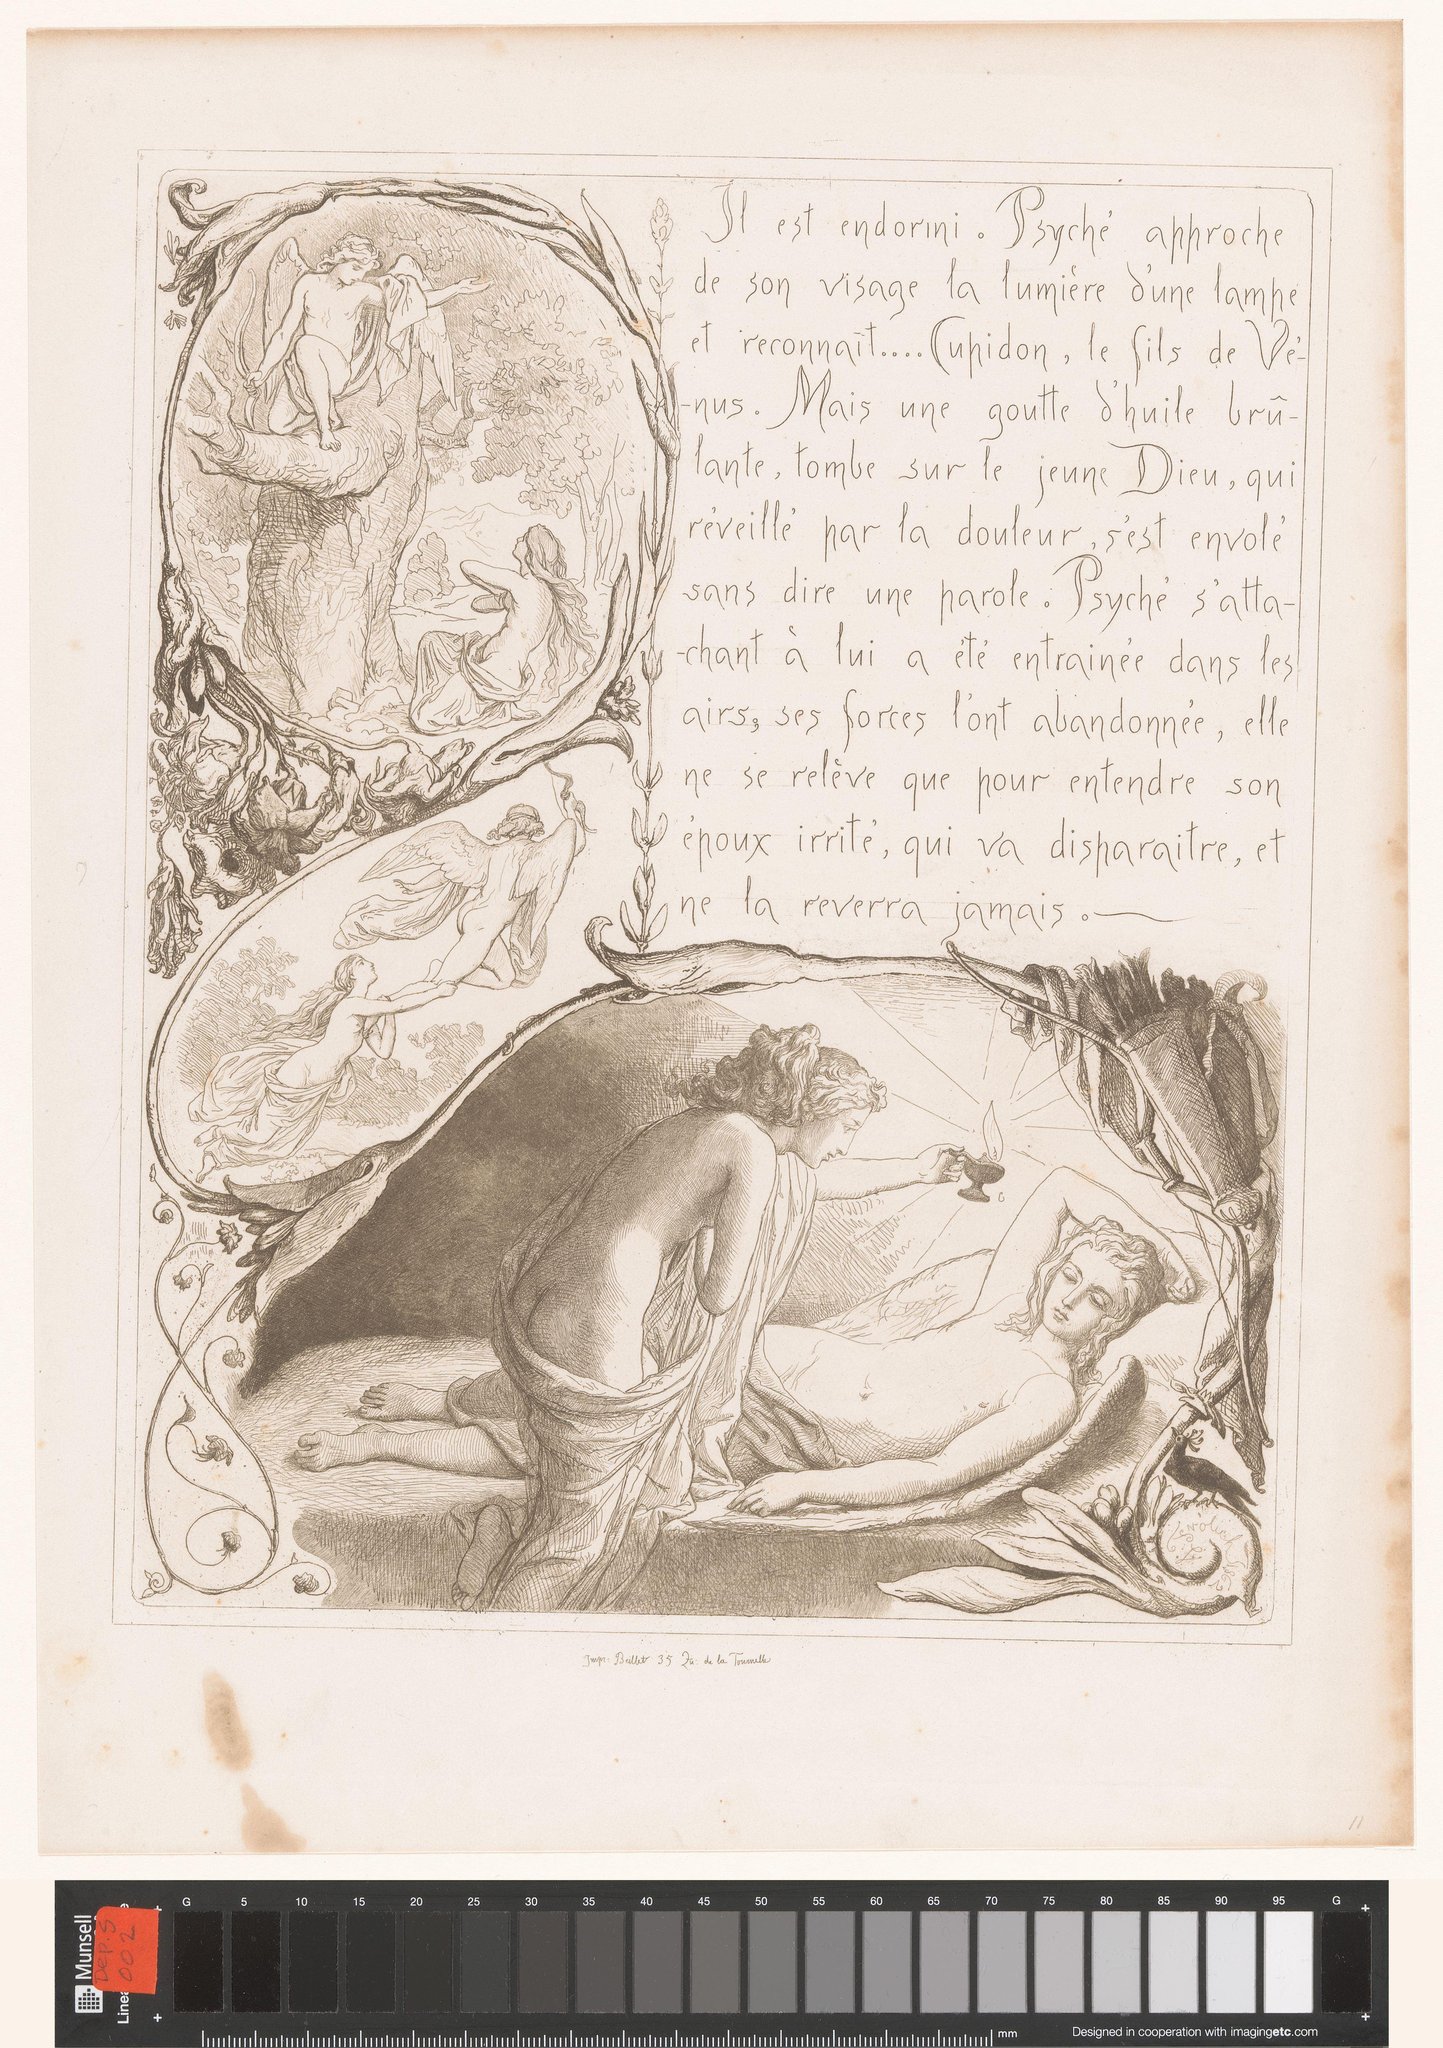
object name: print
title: Amor en Psyche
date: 1862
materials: paper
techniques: etching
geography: paris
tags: story of cupid and psyche (apuleius, 'metamorphoses' (golden ass) iv 28 - vi 25)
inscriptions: collector's mark: Lugt 2228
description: Maakt waarschijnlijk deel uit van een twintigdelige serie met prenten bij het verhaal van Apuleius over Amor en Psyche.